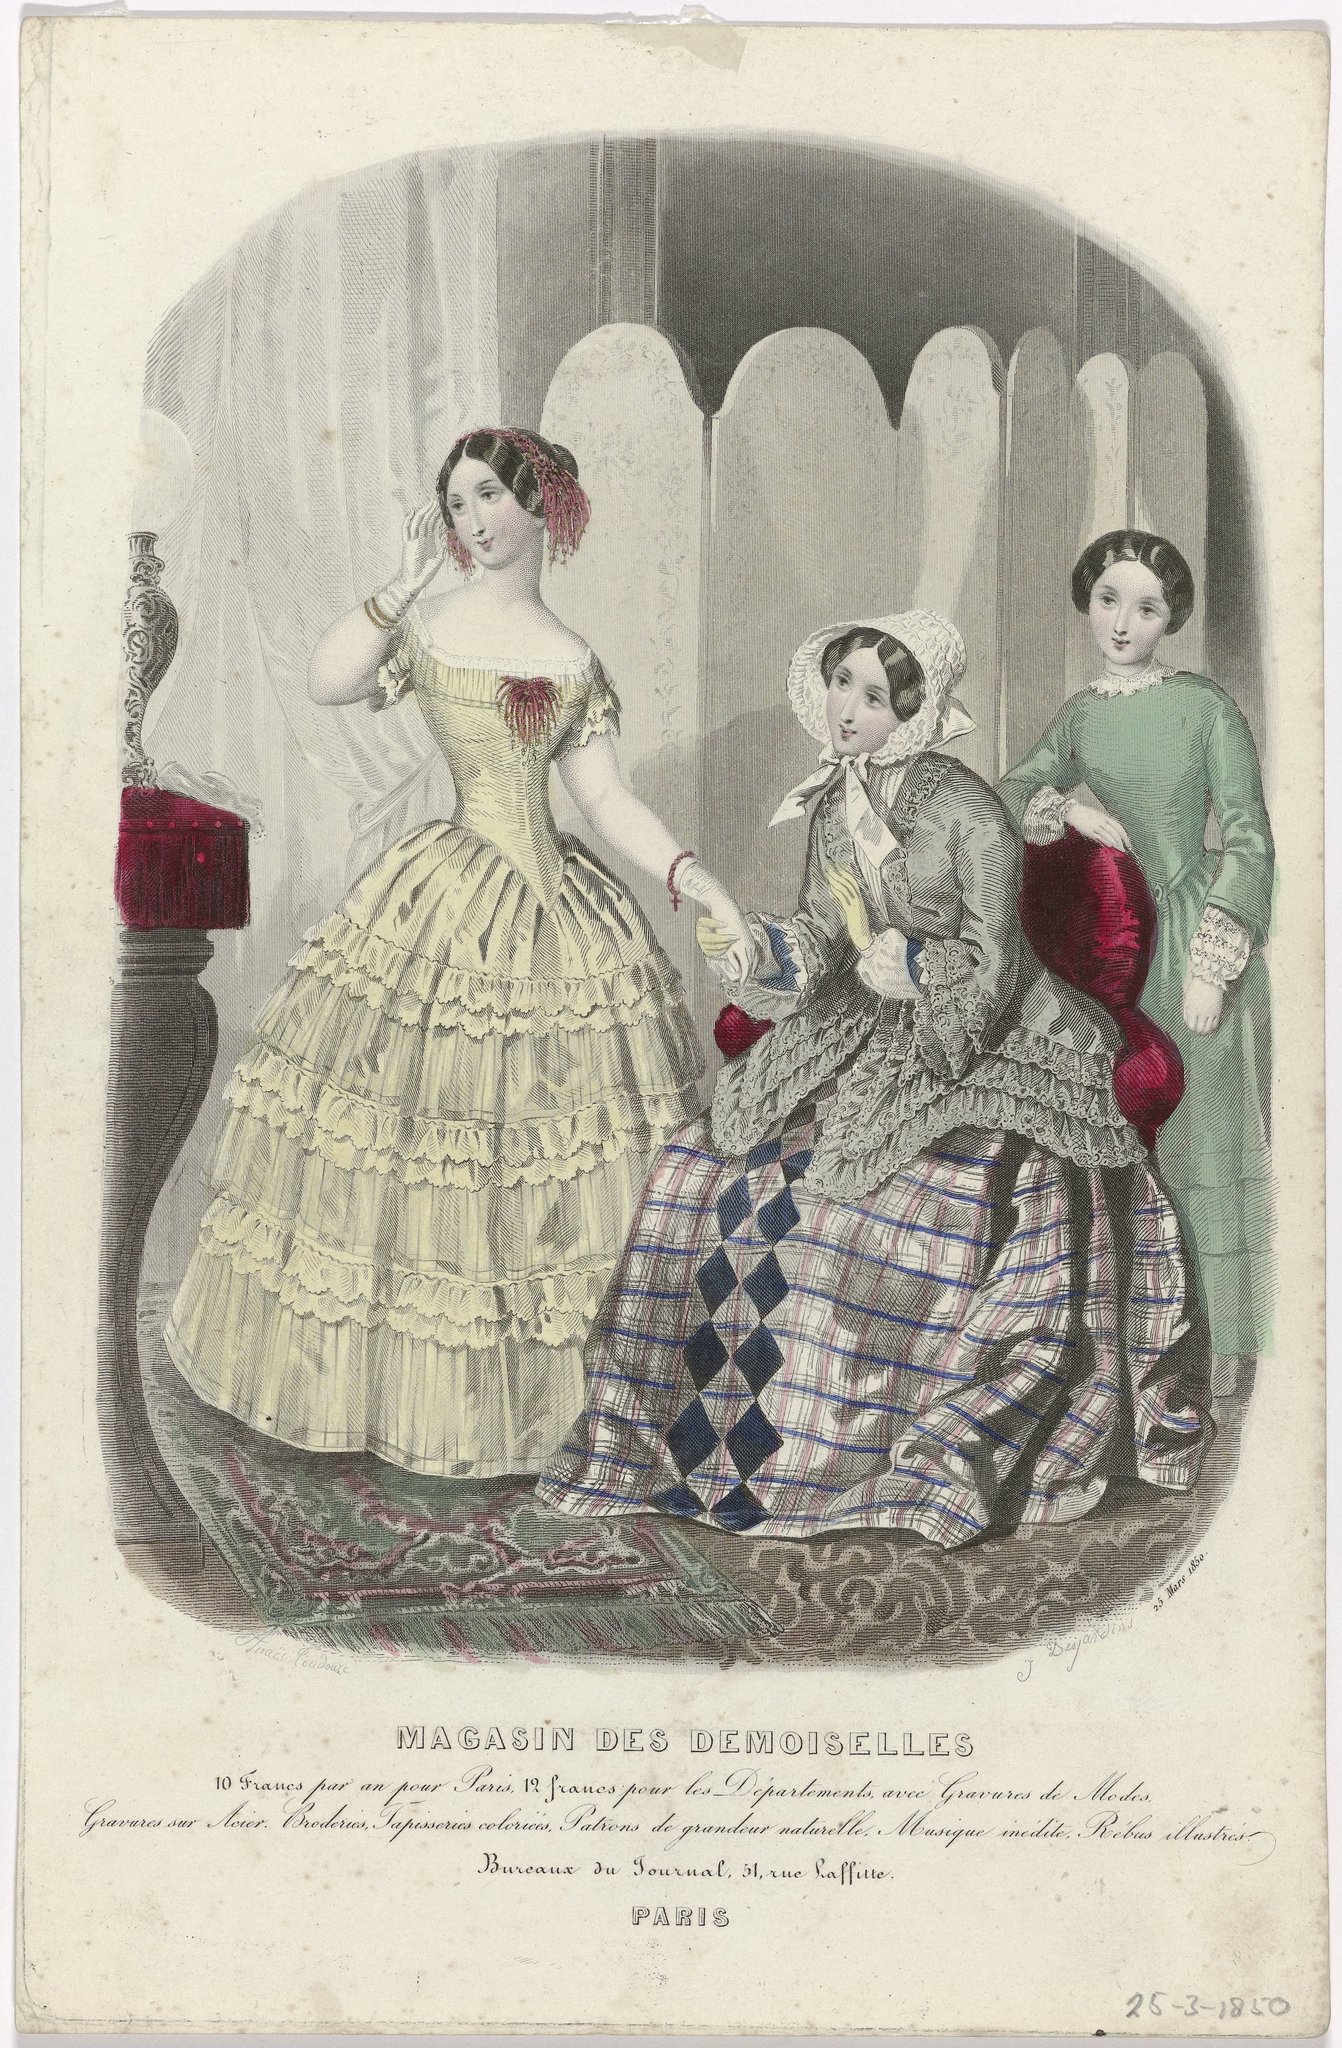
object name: fashion print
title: Magasin des Demoiselles, 25 mars 1850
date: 1850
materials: paper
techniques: hand coloring, engraving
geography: paris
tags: corsage (+ women's clothes), dress, gown: evening dress (+ women's clothes), gloves, mittens (short gloves) (+ women's clothes), head-gear (+ girls' clothes), coat (+ women's clothes), head-gear (+ women's clothes), fashion plates, skirt (+ women's clothes), screen, folding screen, neck-gear ~ clothing (+ women's clothes), bracelet, wristlet (+ women's clothes)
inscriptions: title: ‘Magasin des Demoiselles’, address: ‘Bureaux du Journal, 51, rue Laffitte. / Paris’, caption: ‘10 Francs par an pour Paris 12 francs pour les Départements, avec Gravures de Modes, Gravures sur Acier. Broderies, Tapisseries coloriées, Patrons de grandeur naturelle, Musique inédite, Rébus illustrés’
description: Drie vrouwen, van wie één zittend, in een interieur. Op de achtergrond een kamerscherm. Links: gele avondjapon met boothals, korte mouwen en puntig lijfje. Gestreepte wijde rok, versierd met gerimpelde stroken stof. Haarband(?) en eenzelfde soort corsage. Korte handschoenen met knopen. Armbanden om beide polsen, waarvan één met hanger in de vorm van een kruis. Midden: korte mantel met wijd uitlopende mouwen op een geruite rok. Rechts: hooggesloten groene japon. Onder de voorstelling enkele regels informatie over het modetijdschrift. Prent uit het modetijdschrift Magasin des Demoiselles (1844-1896).